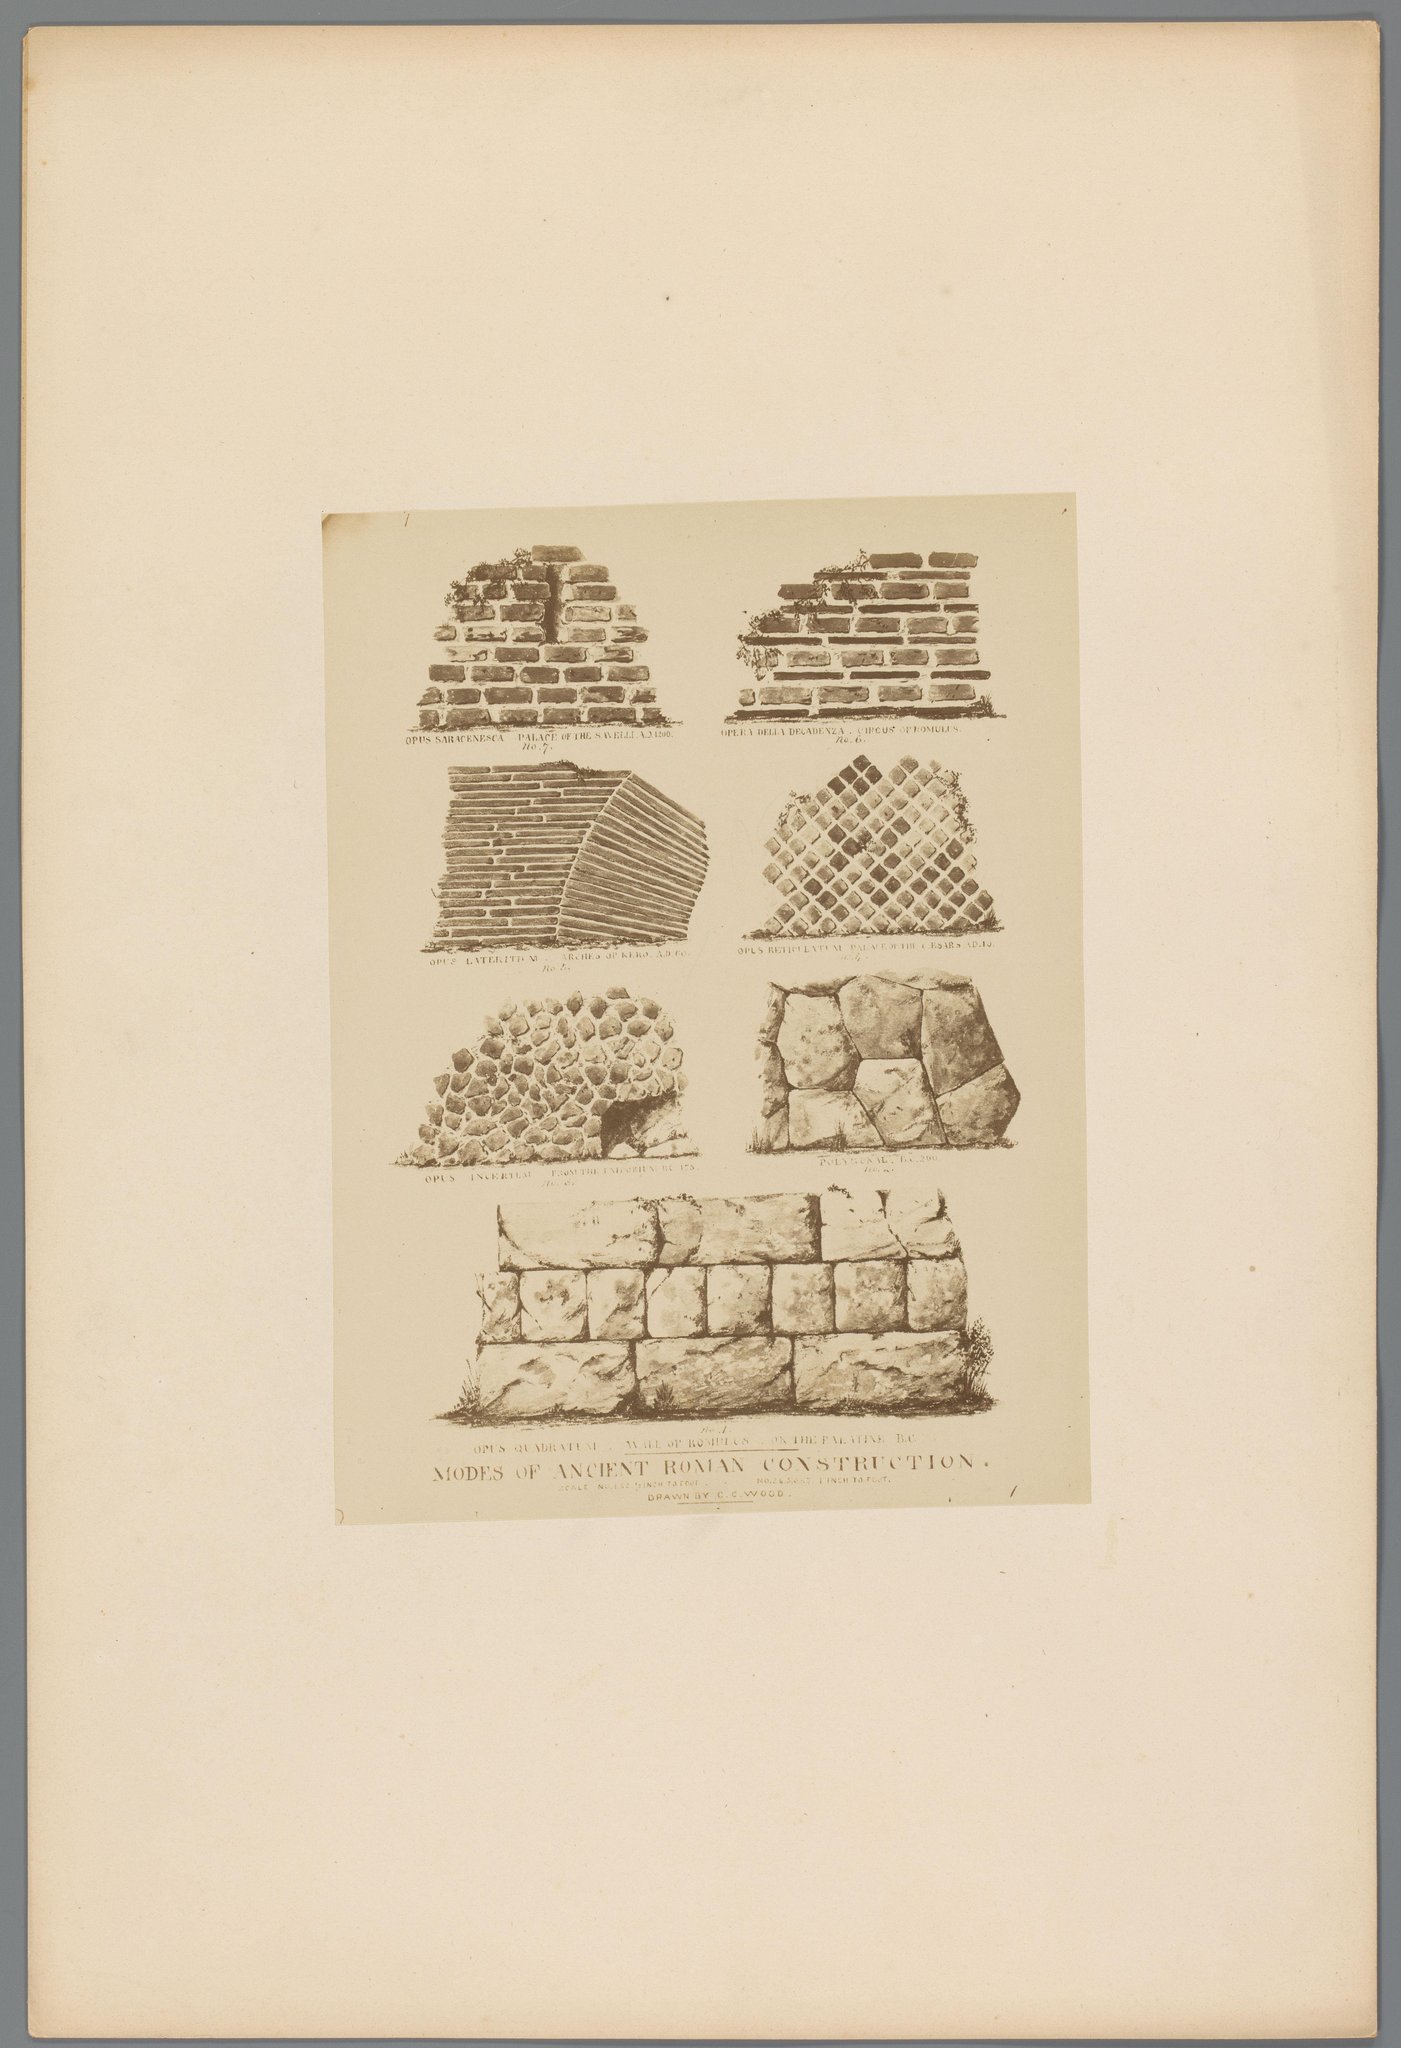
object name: reproduction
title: Modes of Ancient Roman Construction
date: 1863-1887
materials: cardboard, paper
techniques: albumen print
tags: drawing, stone ~ building material